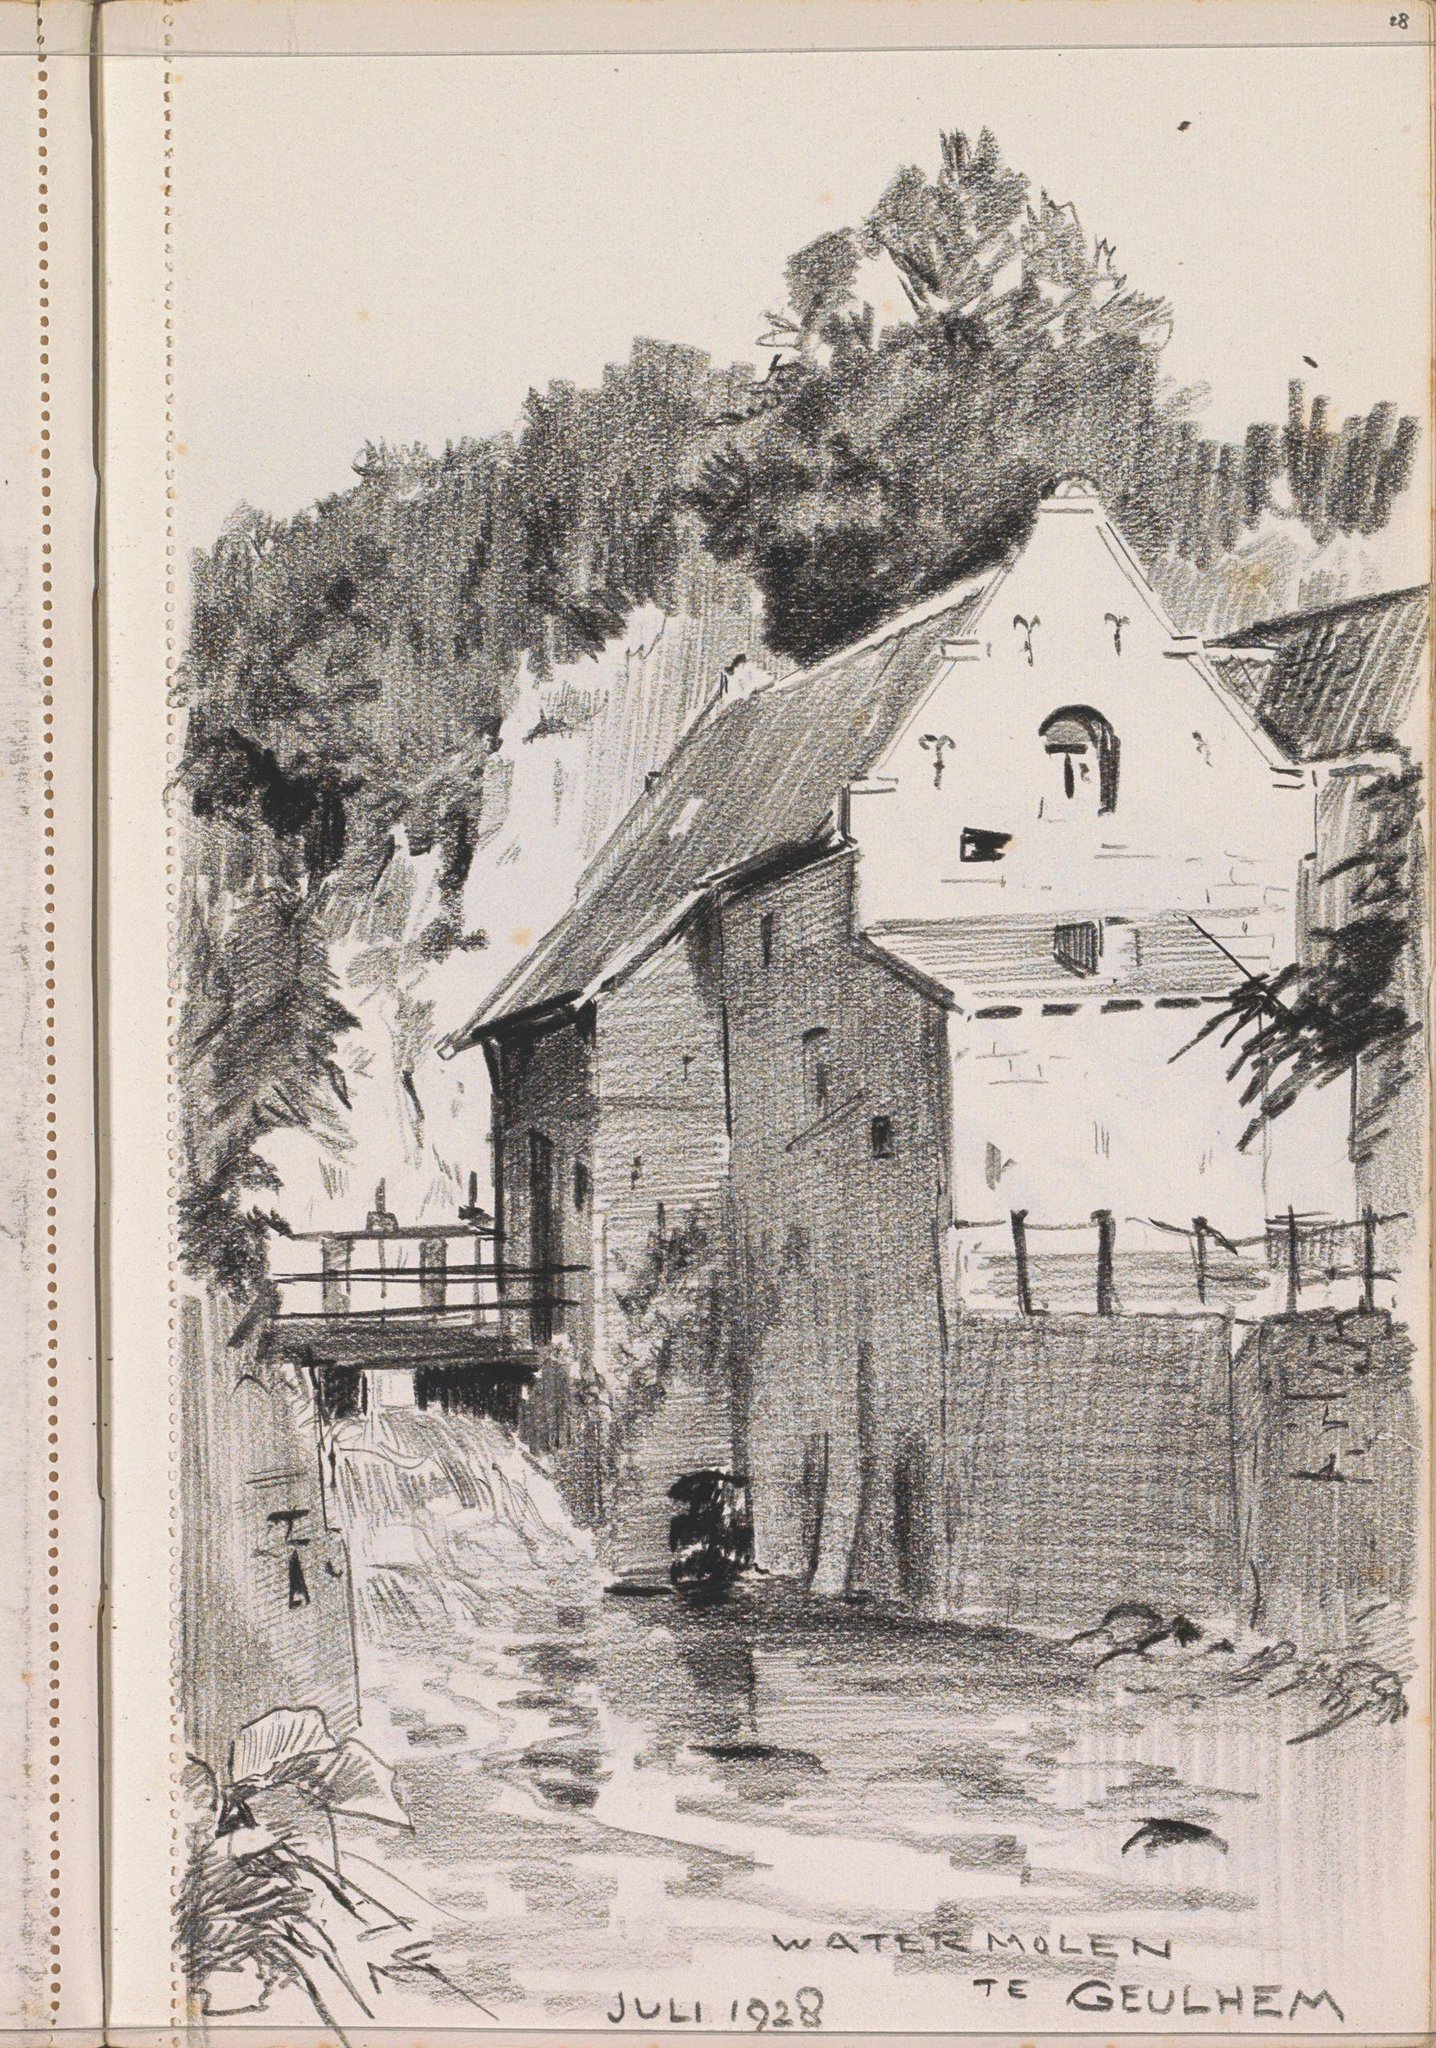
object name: sketchbook leaf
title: Geulhemmermolen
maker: otto verhagen (i)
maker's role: draughtsman, print maker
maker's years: 1885-1951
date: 1907-1928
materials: chalk, paper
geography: geulhem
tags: watermill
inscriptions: date and inscription: ‘WATERMOLEN/ TE GEULHEM/ JULI 1928’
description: Pagina 28 uit een schetsboek met 51 bladen.